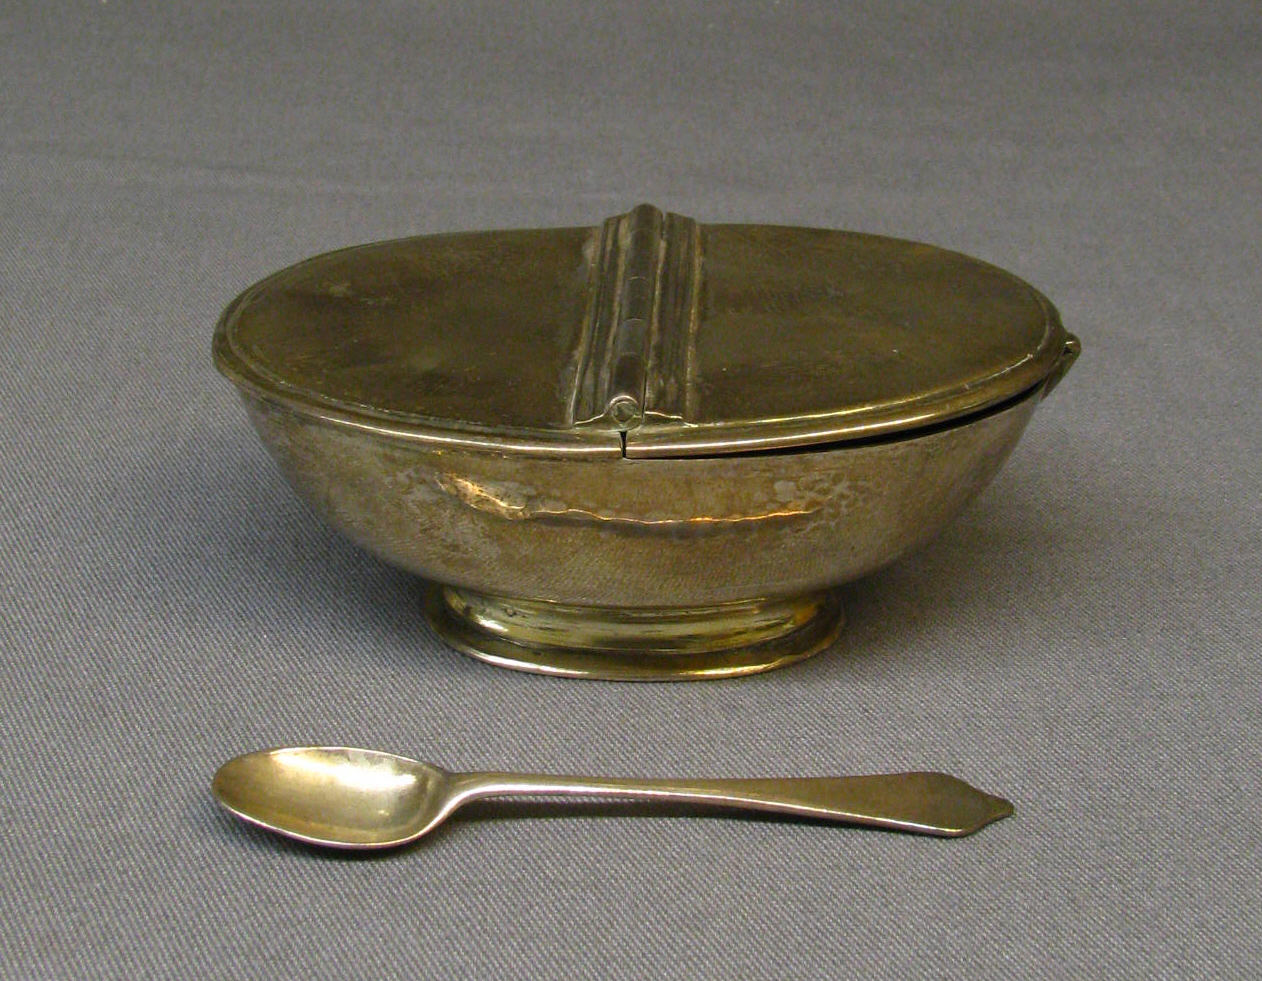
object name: incense boat and spoon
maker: benjamin pyne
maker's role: maker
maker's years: 1693-1727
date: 1708-1709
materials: silver